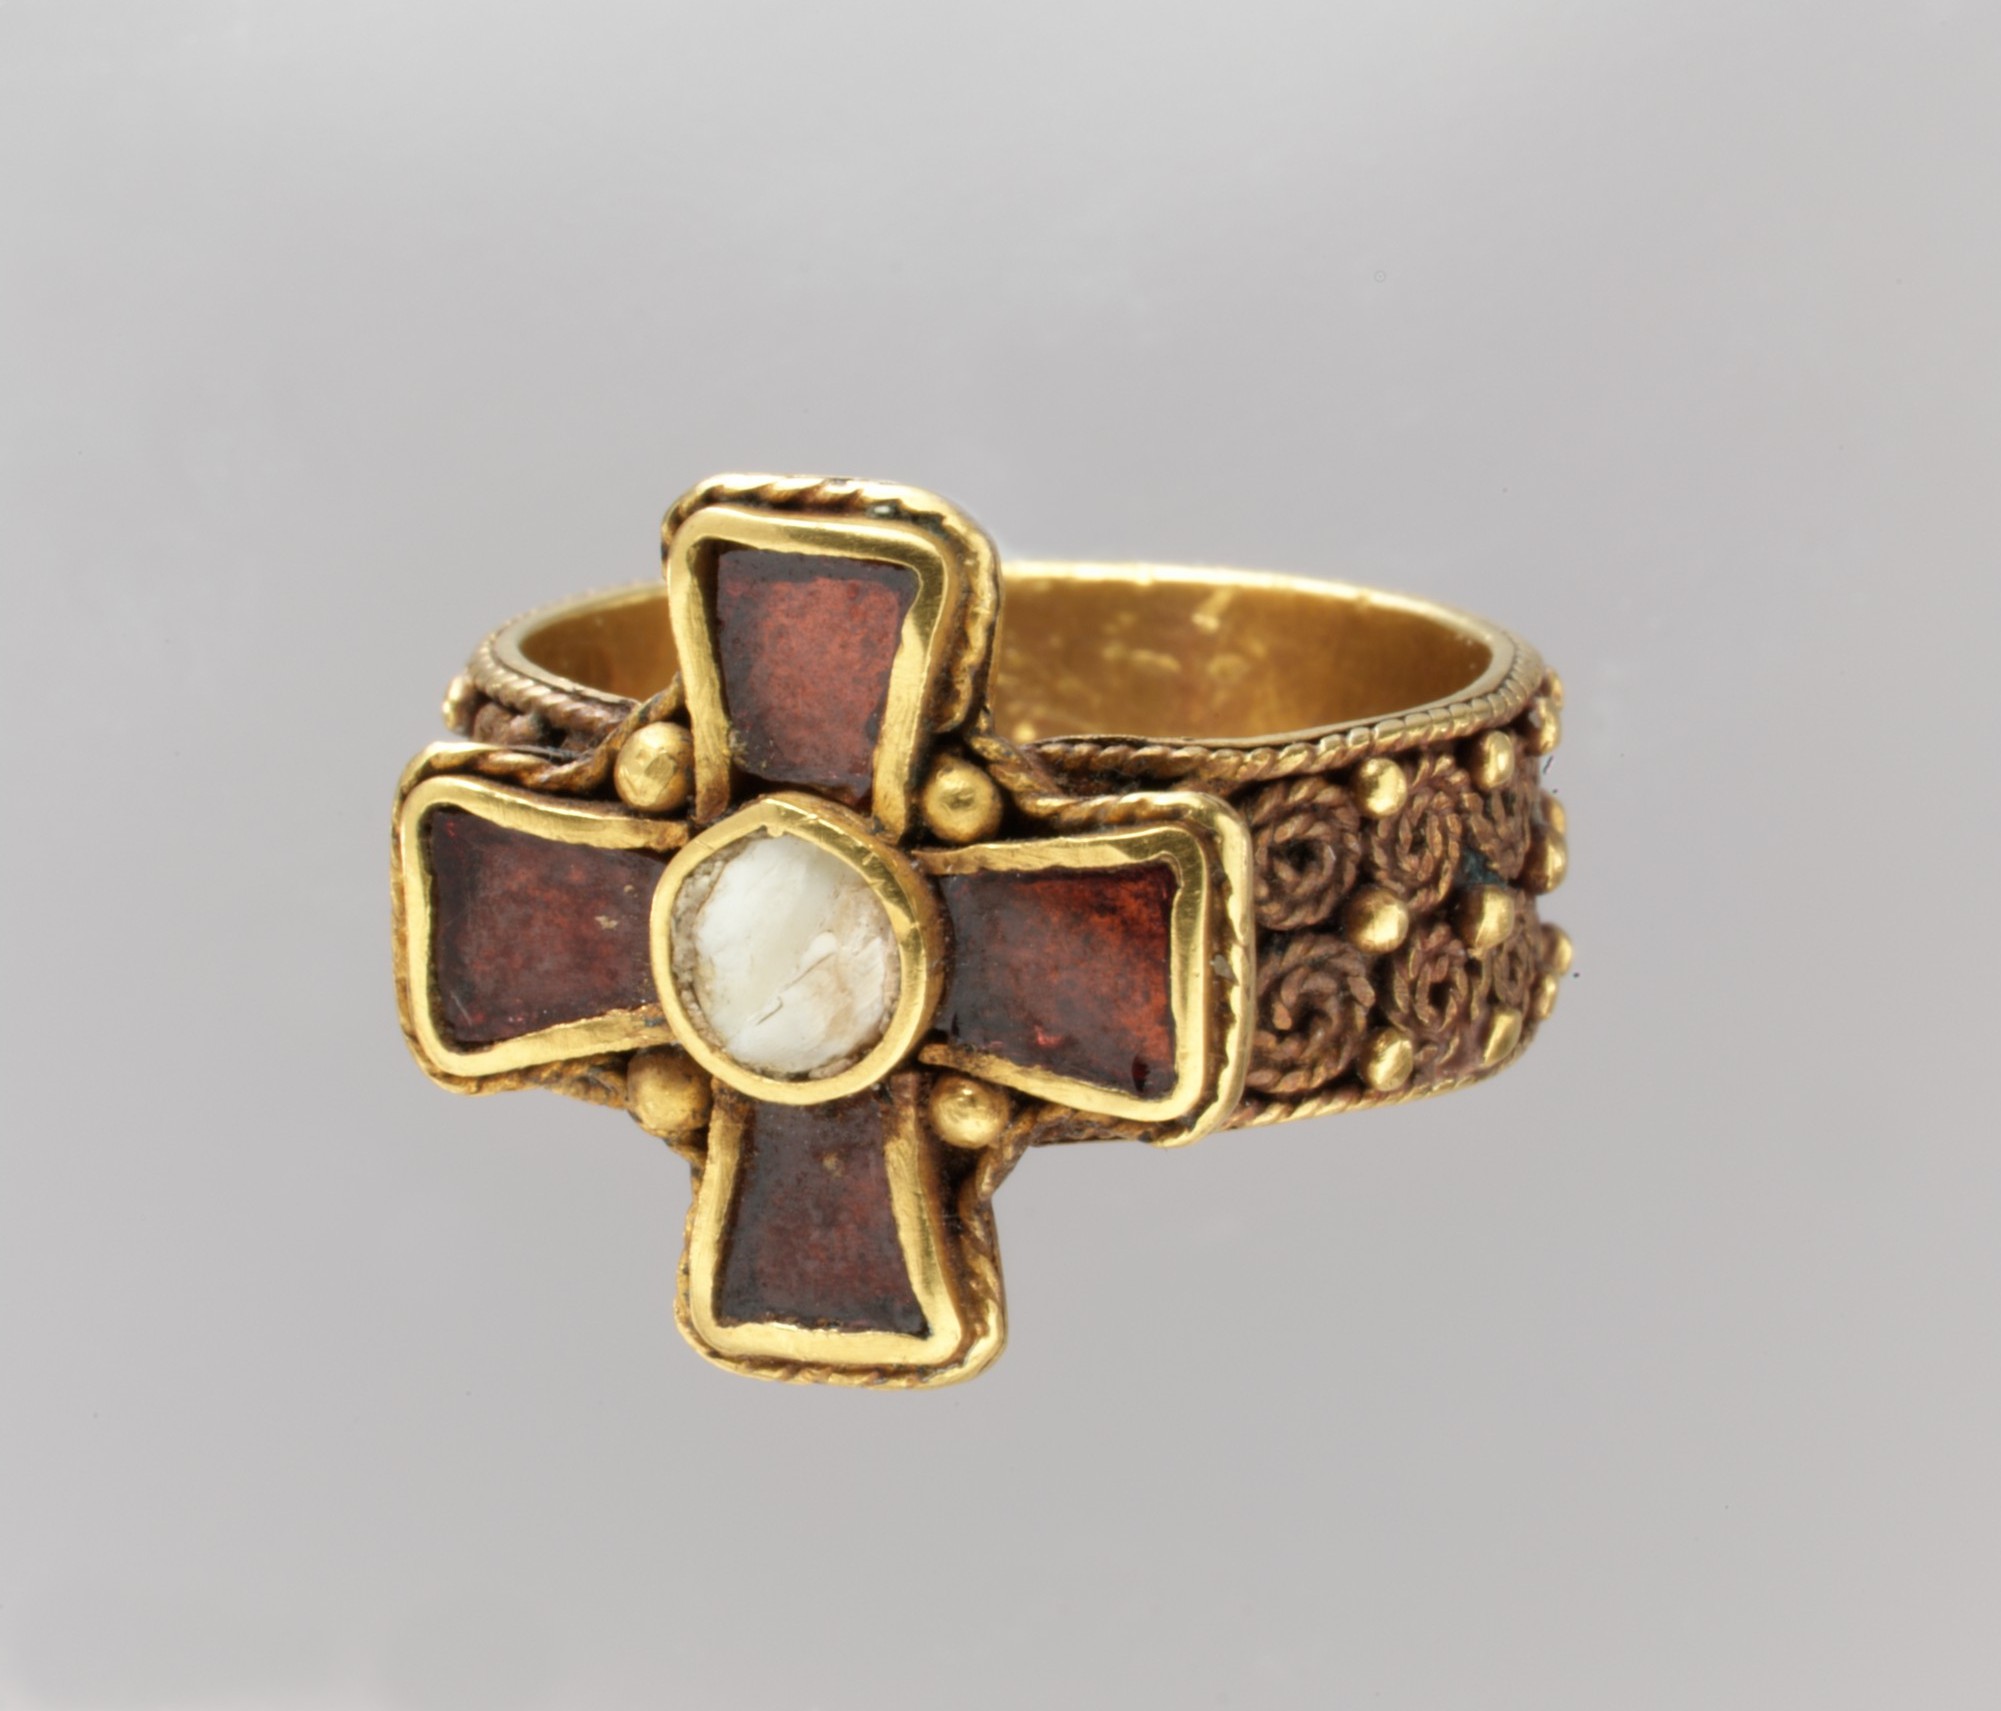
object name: ring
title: Finger Ring with a Cross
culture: frankish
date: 450-525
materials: gold